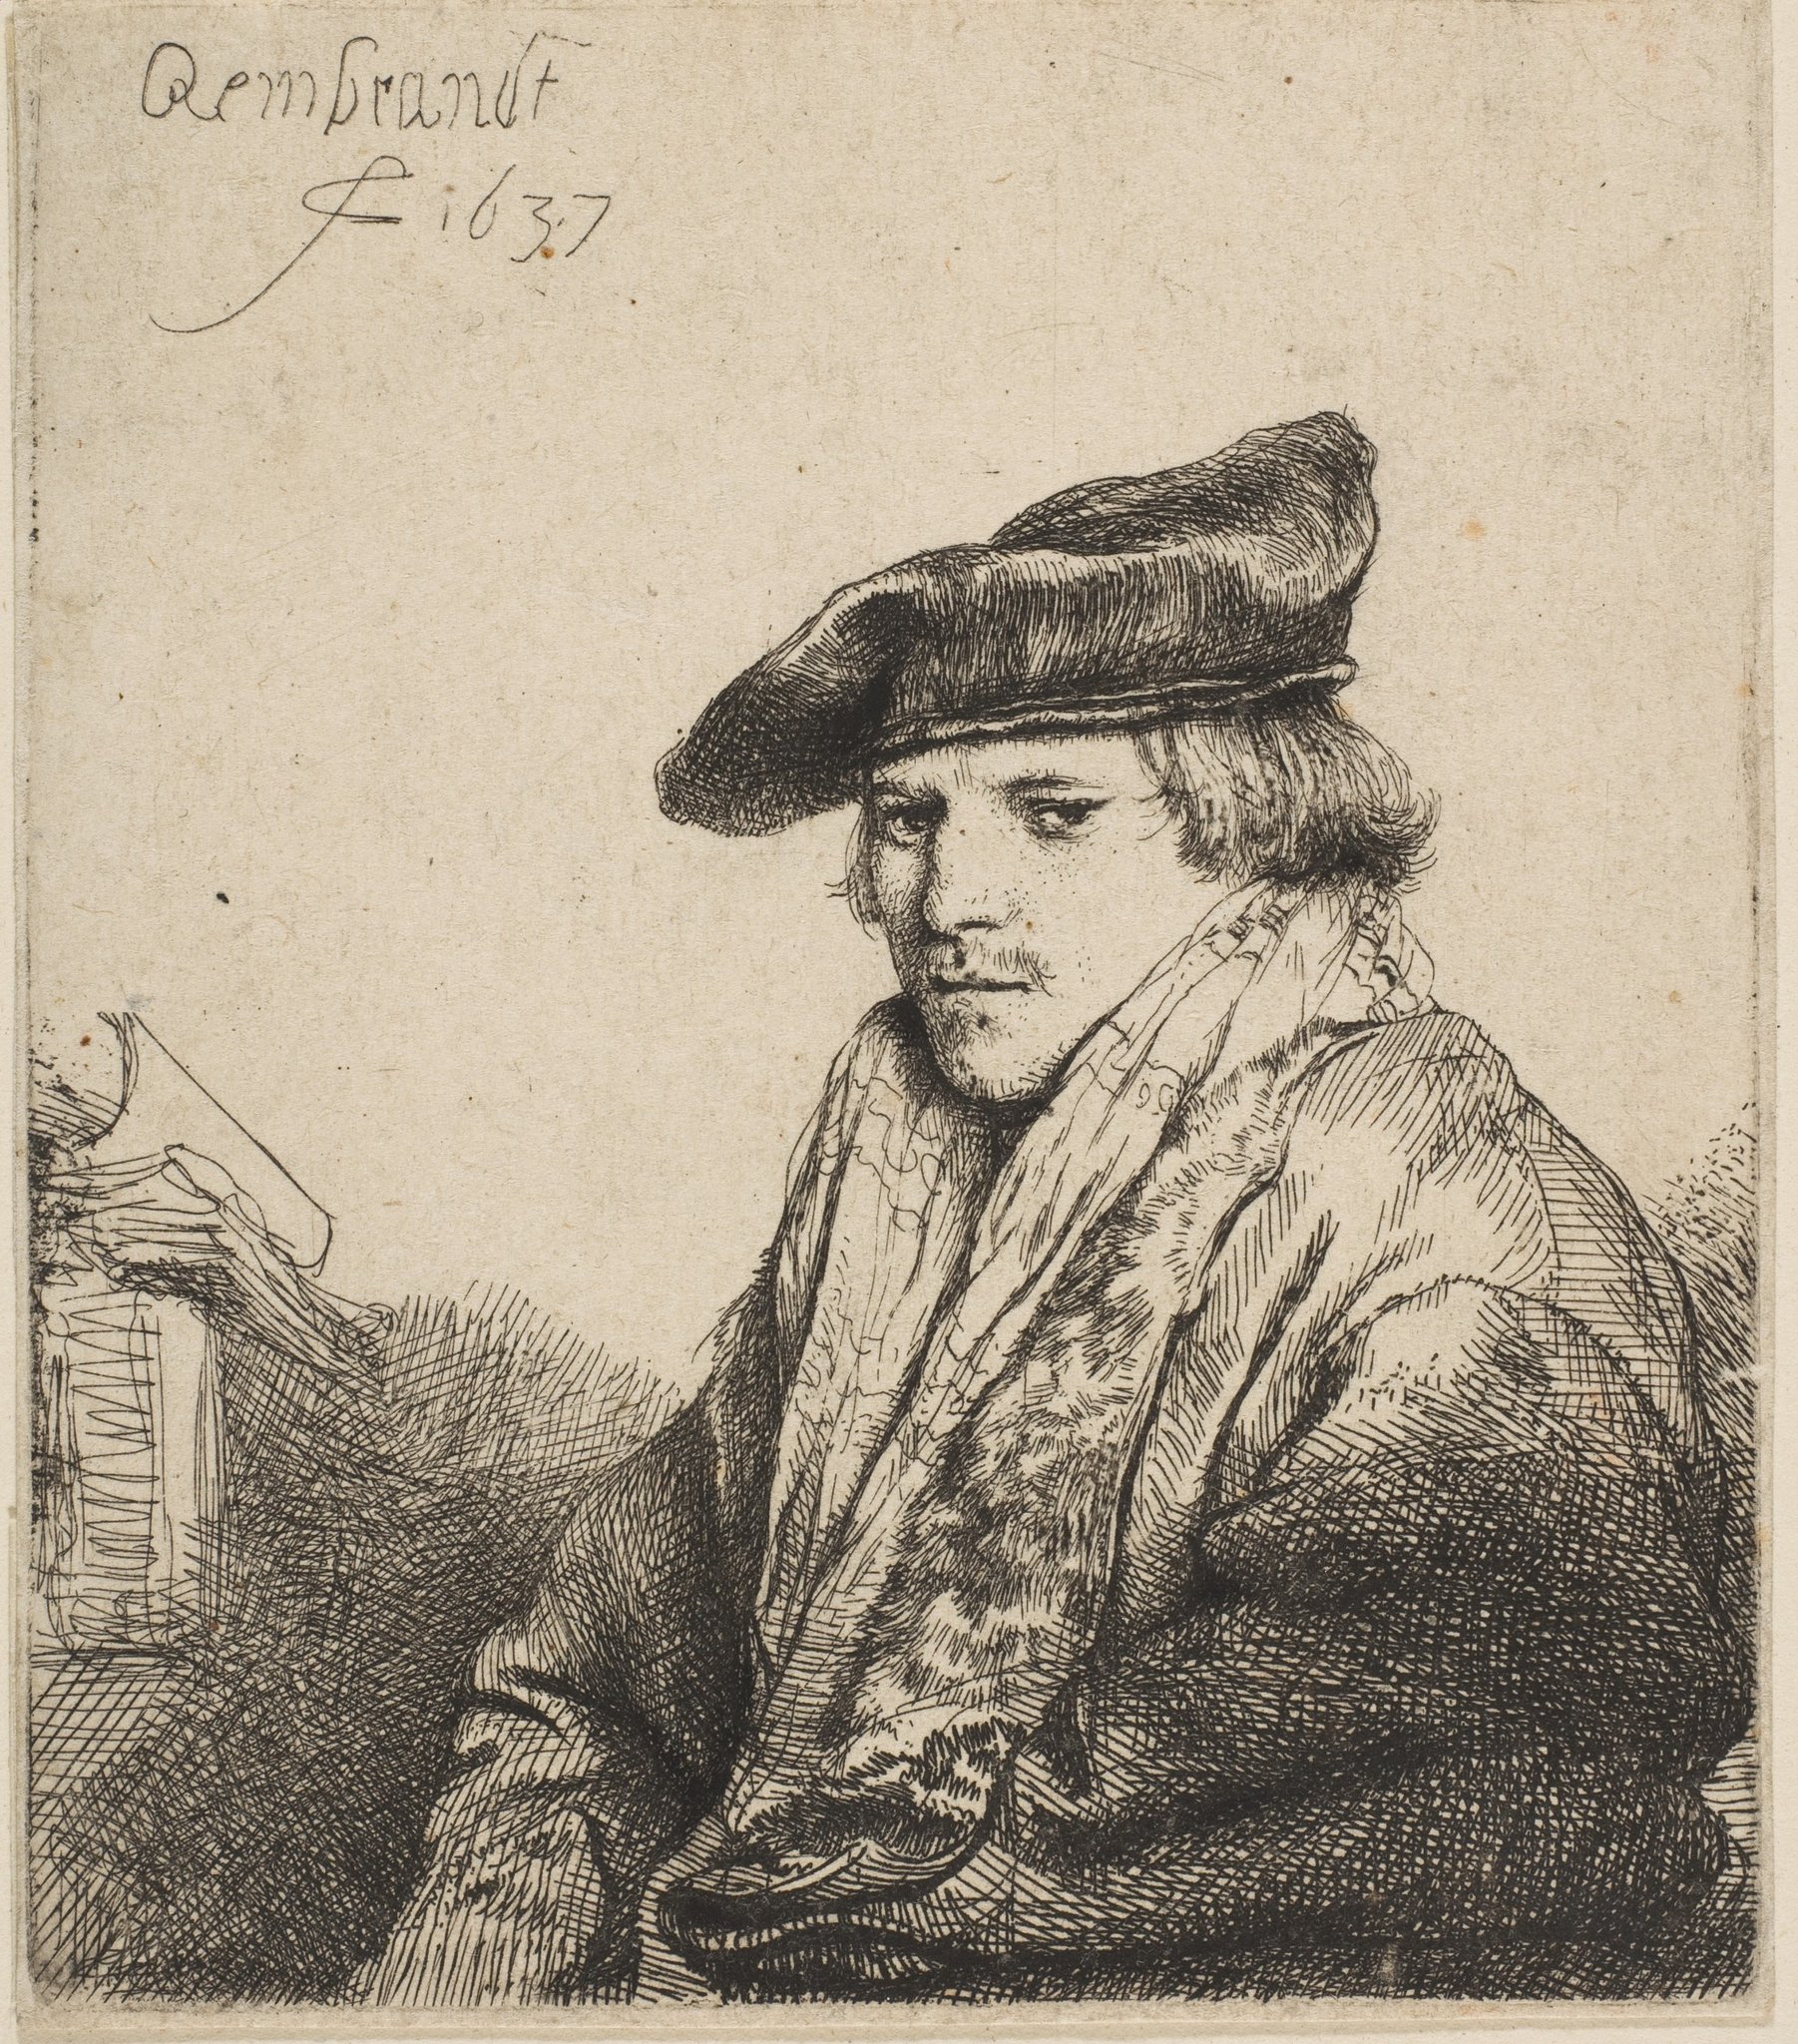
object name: print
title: Young Man in a Velvet Cap (Ferdinand Bol)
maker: rembrandt van rijn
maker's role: artist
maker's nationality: dutch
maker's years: 1606-1669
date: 1637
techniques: etching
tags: men,portraits